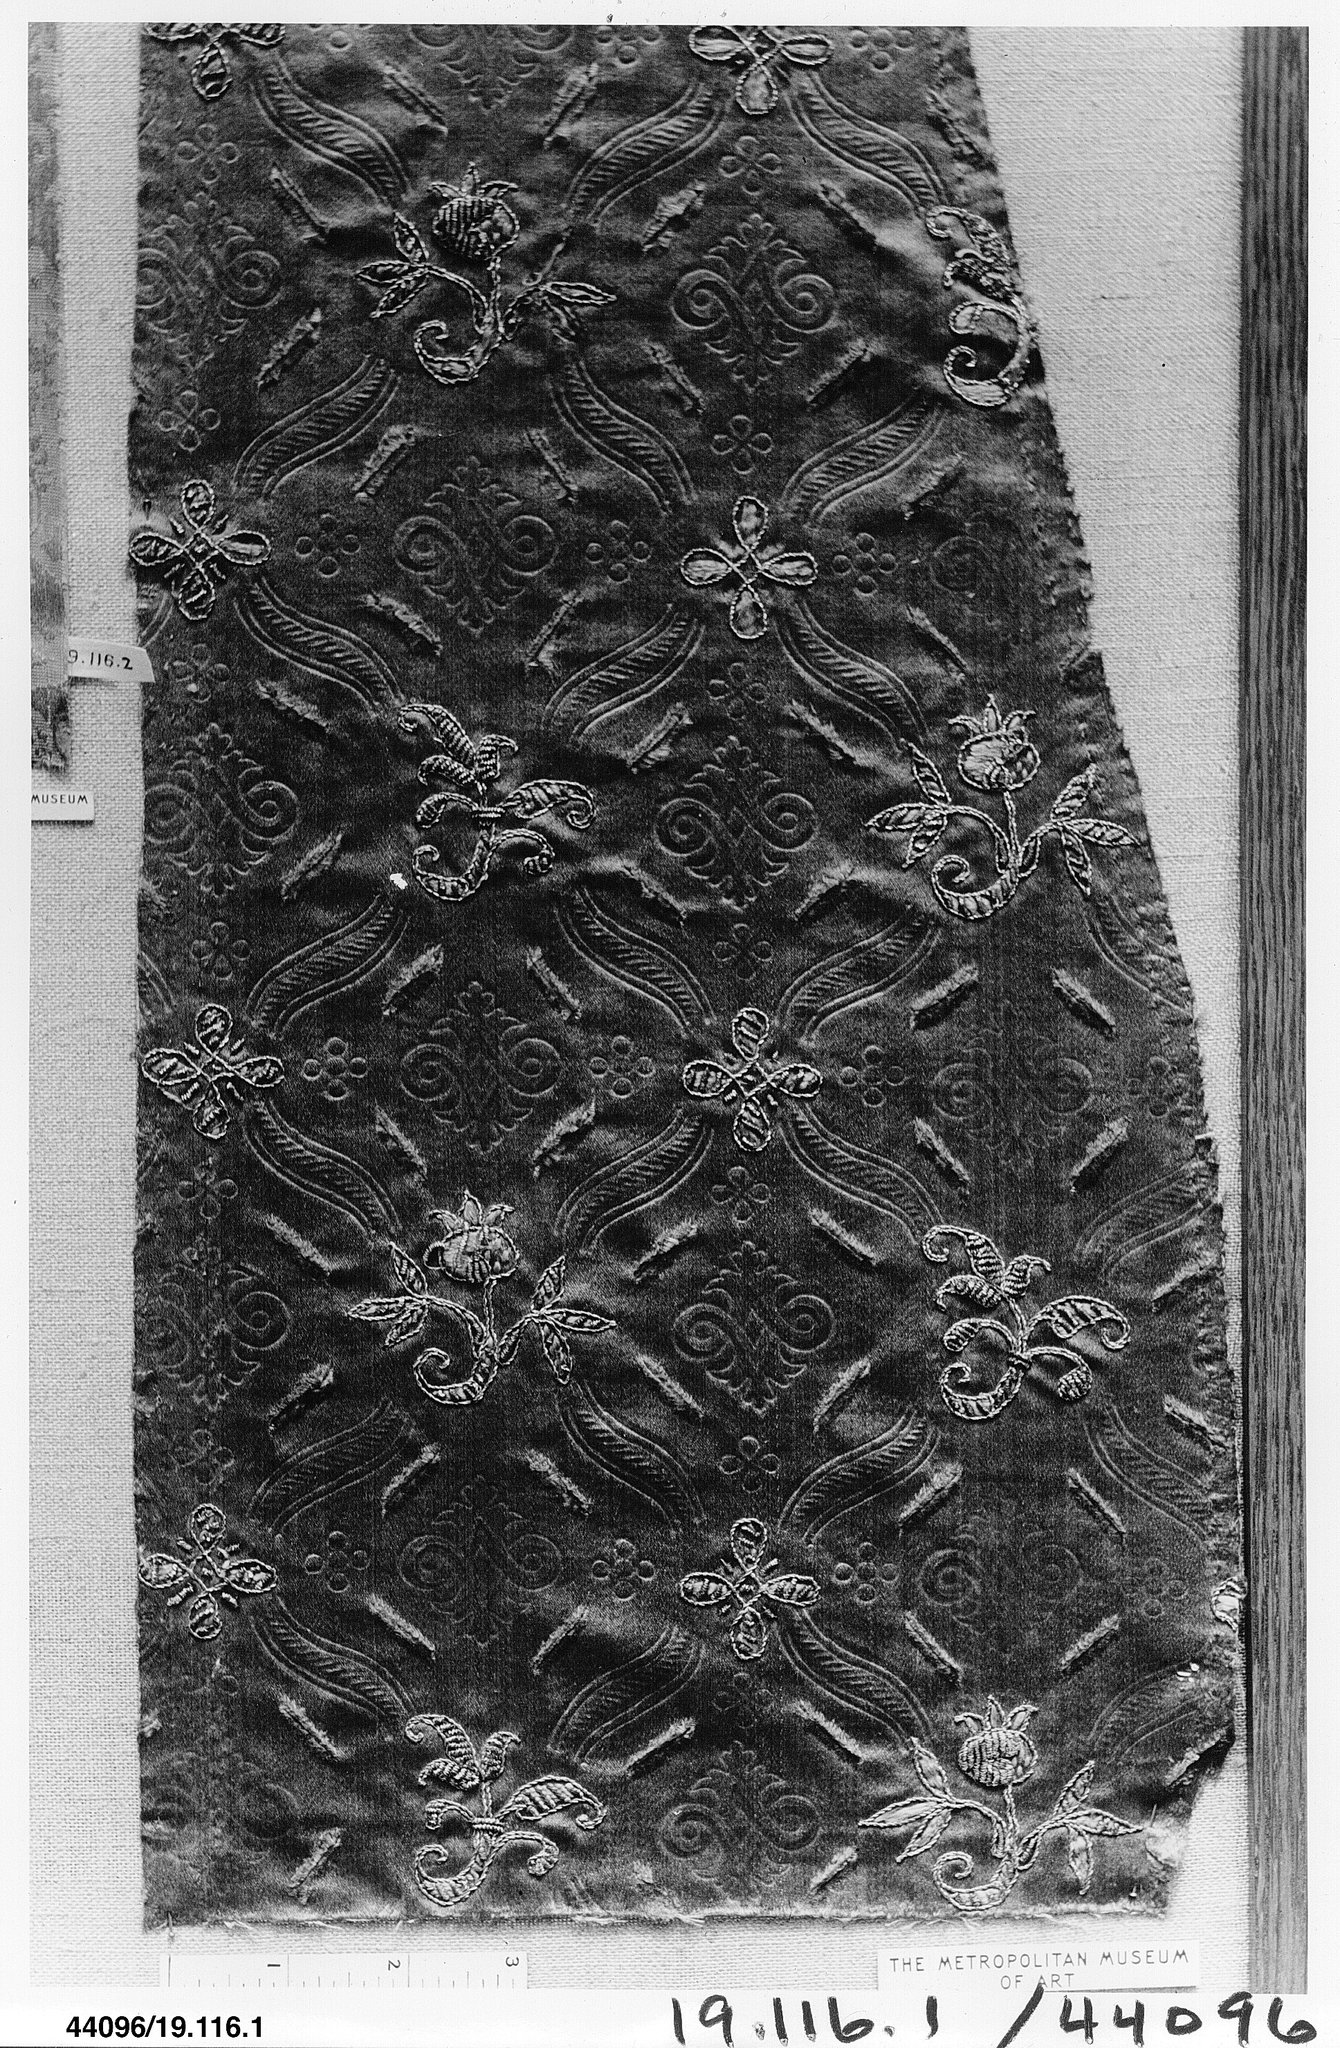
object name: fragment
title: Fragment of satin with stamped, slashed and embroidered decoration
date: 1601-1633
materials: metal thread, silk